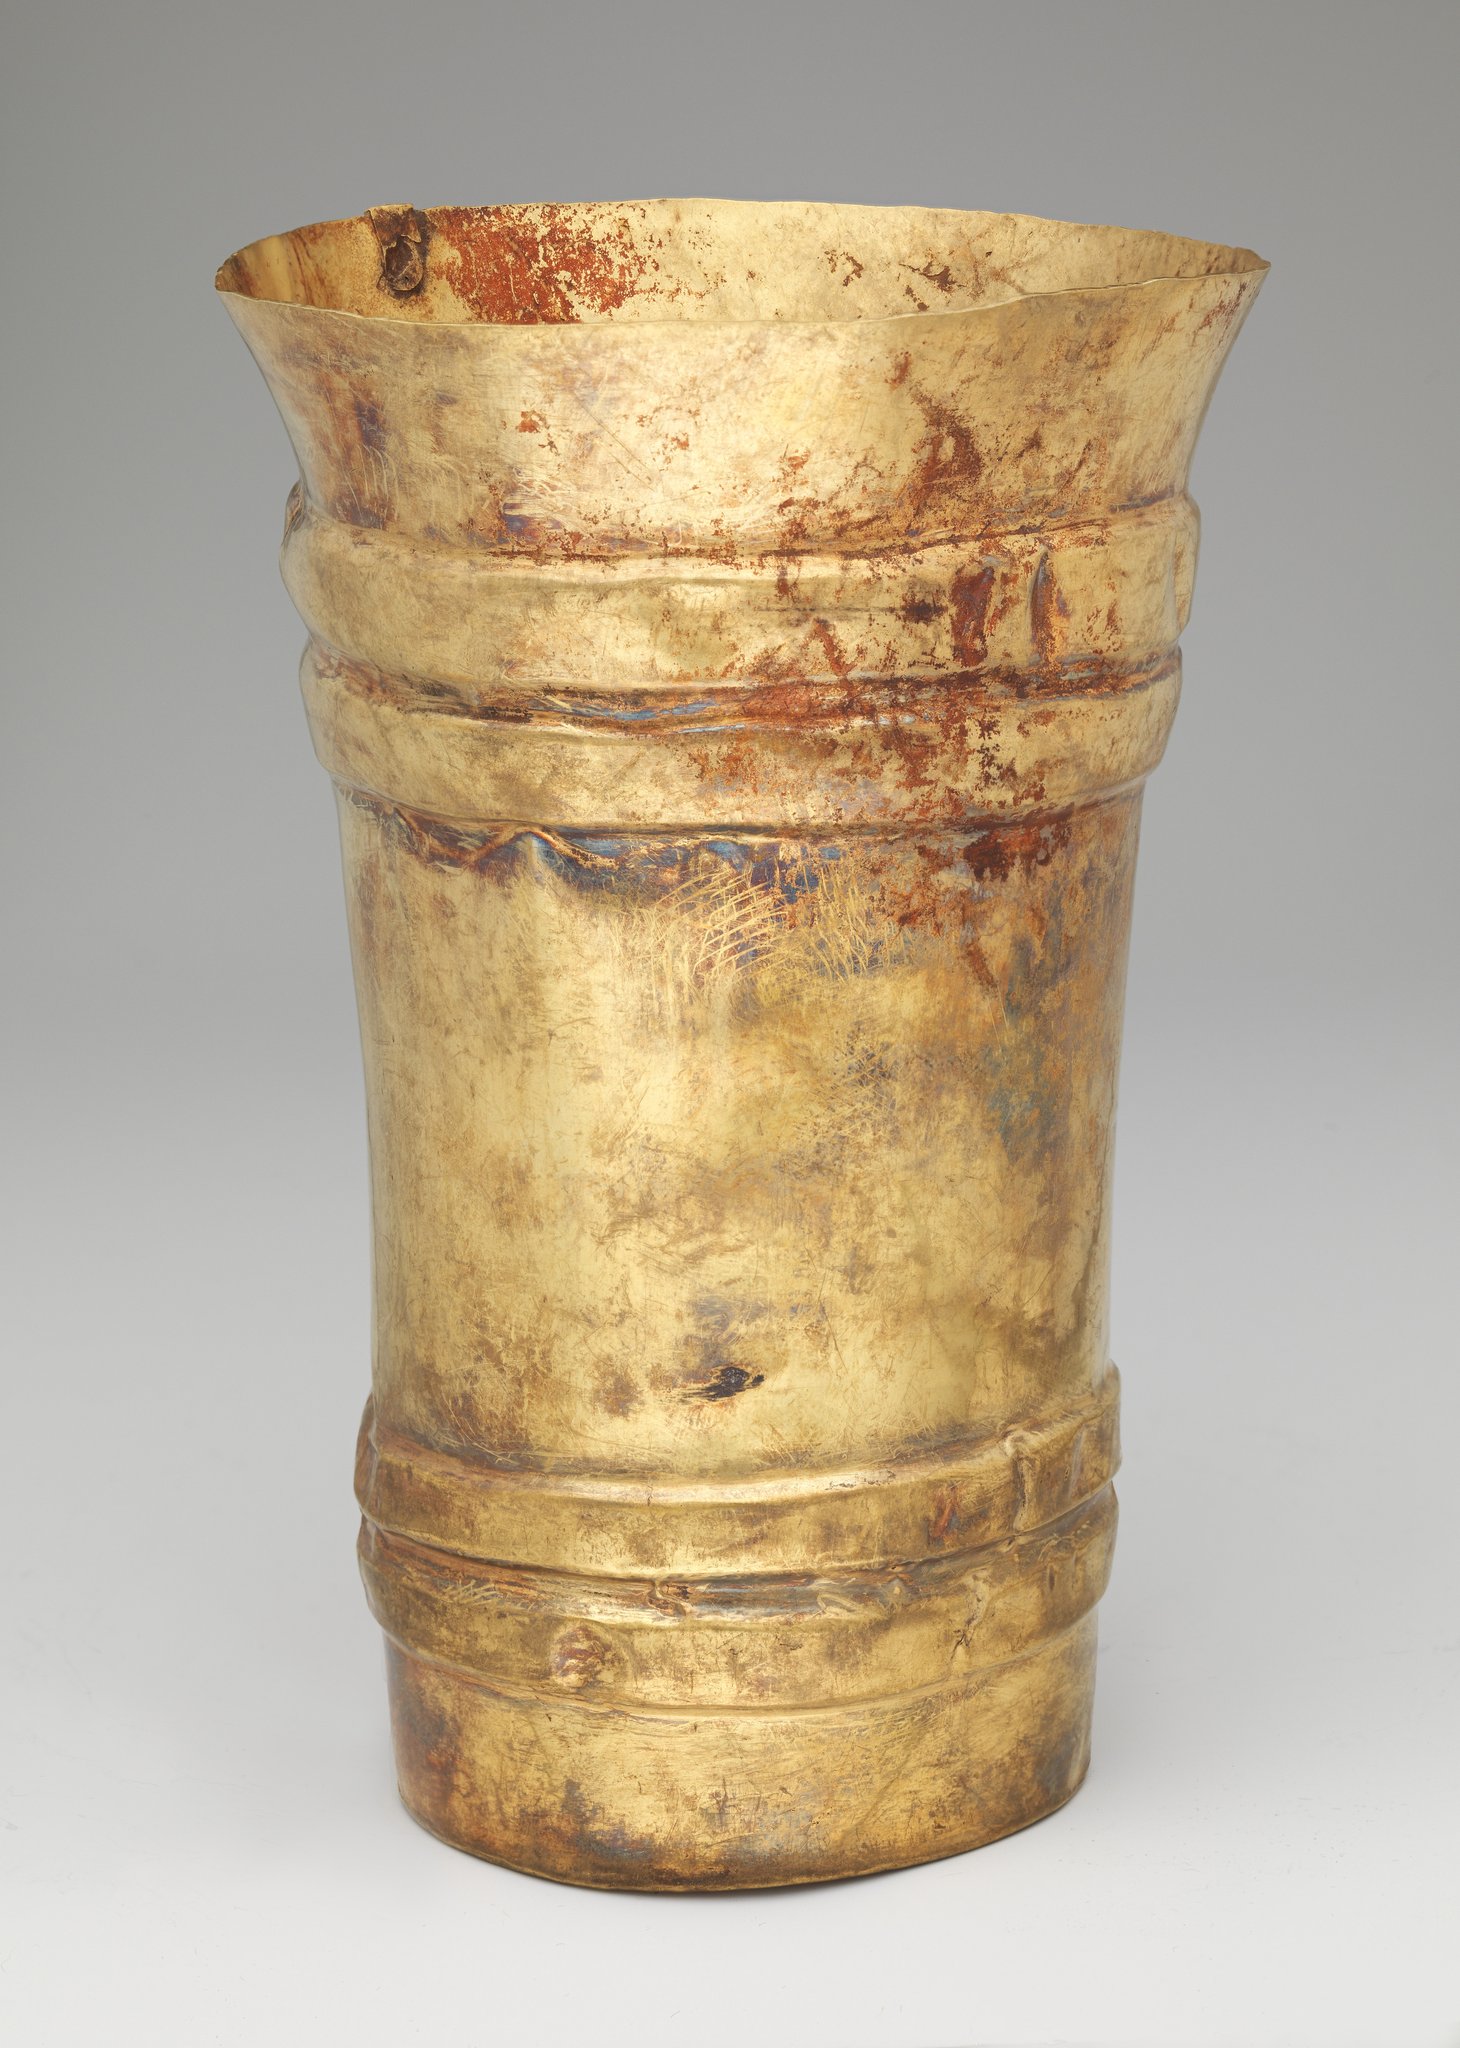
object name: beaker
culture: lambayeque, sicán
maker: lambayeque (sicán) artist(s)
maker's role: artist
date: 900-1100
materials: gold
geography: peru